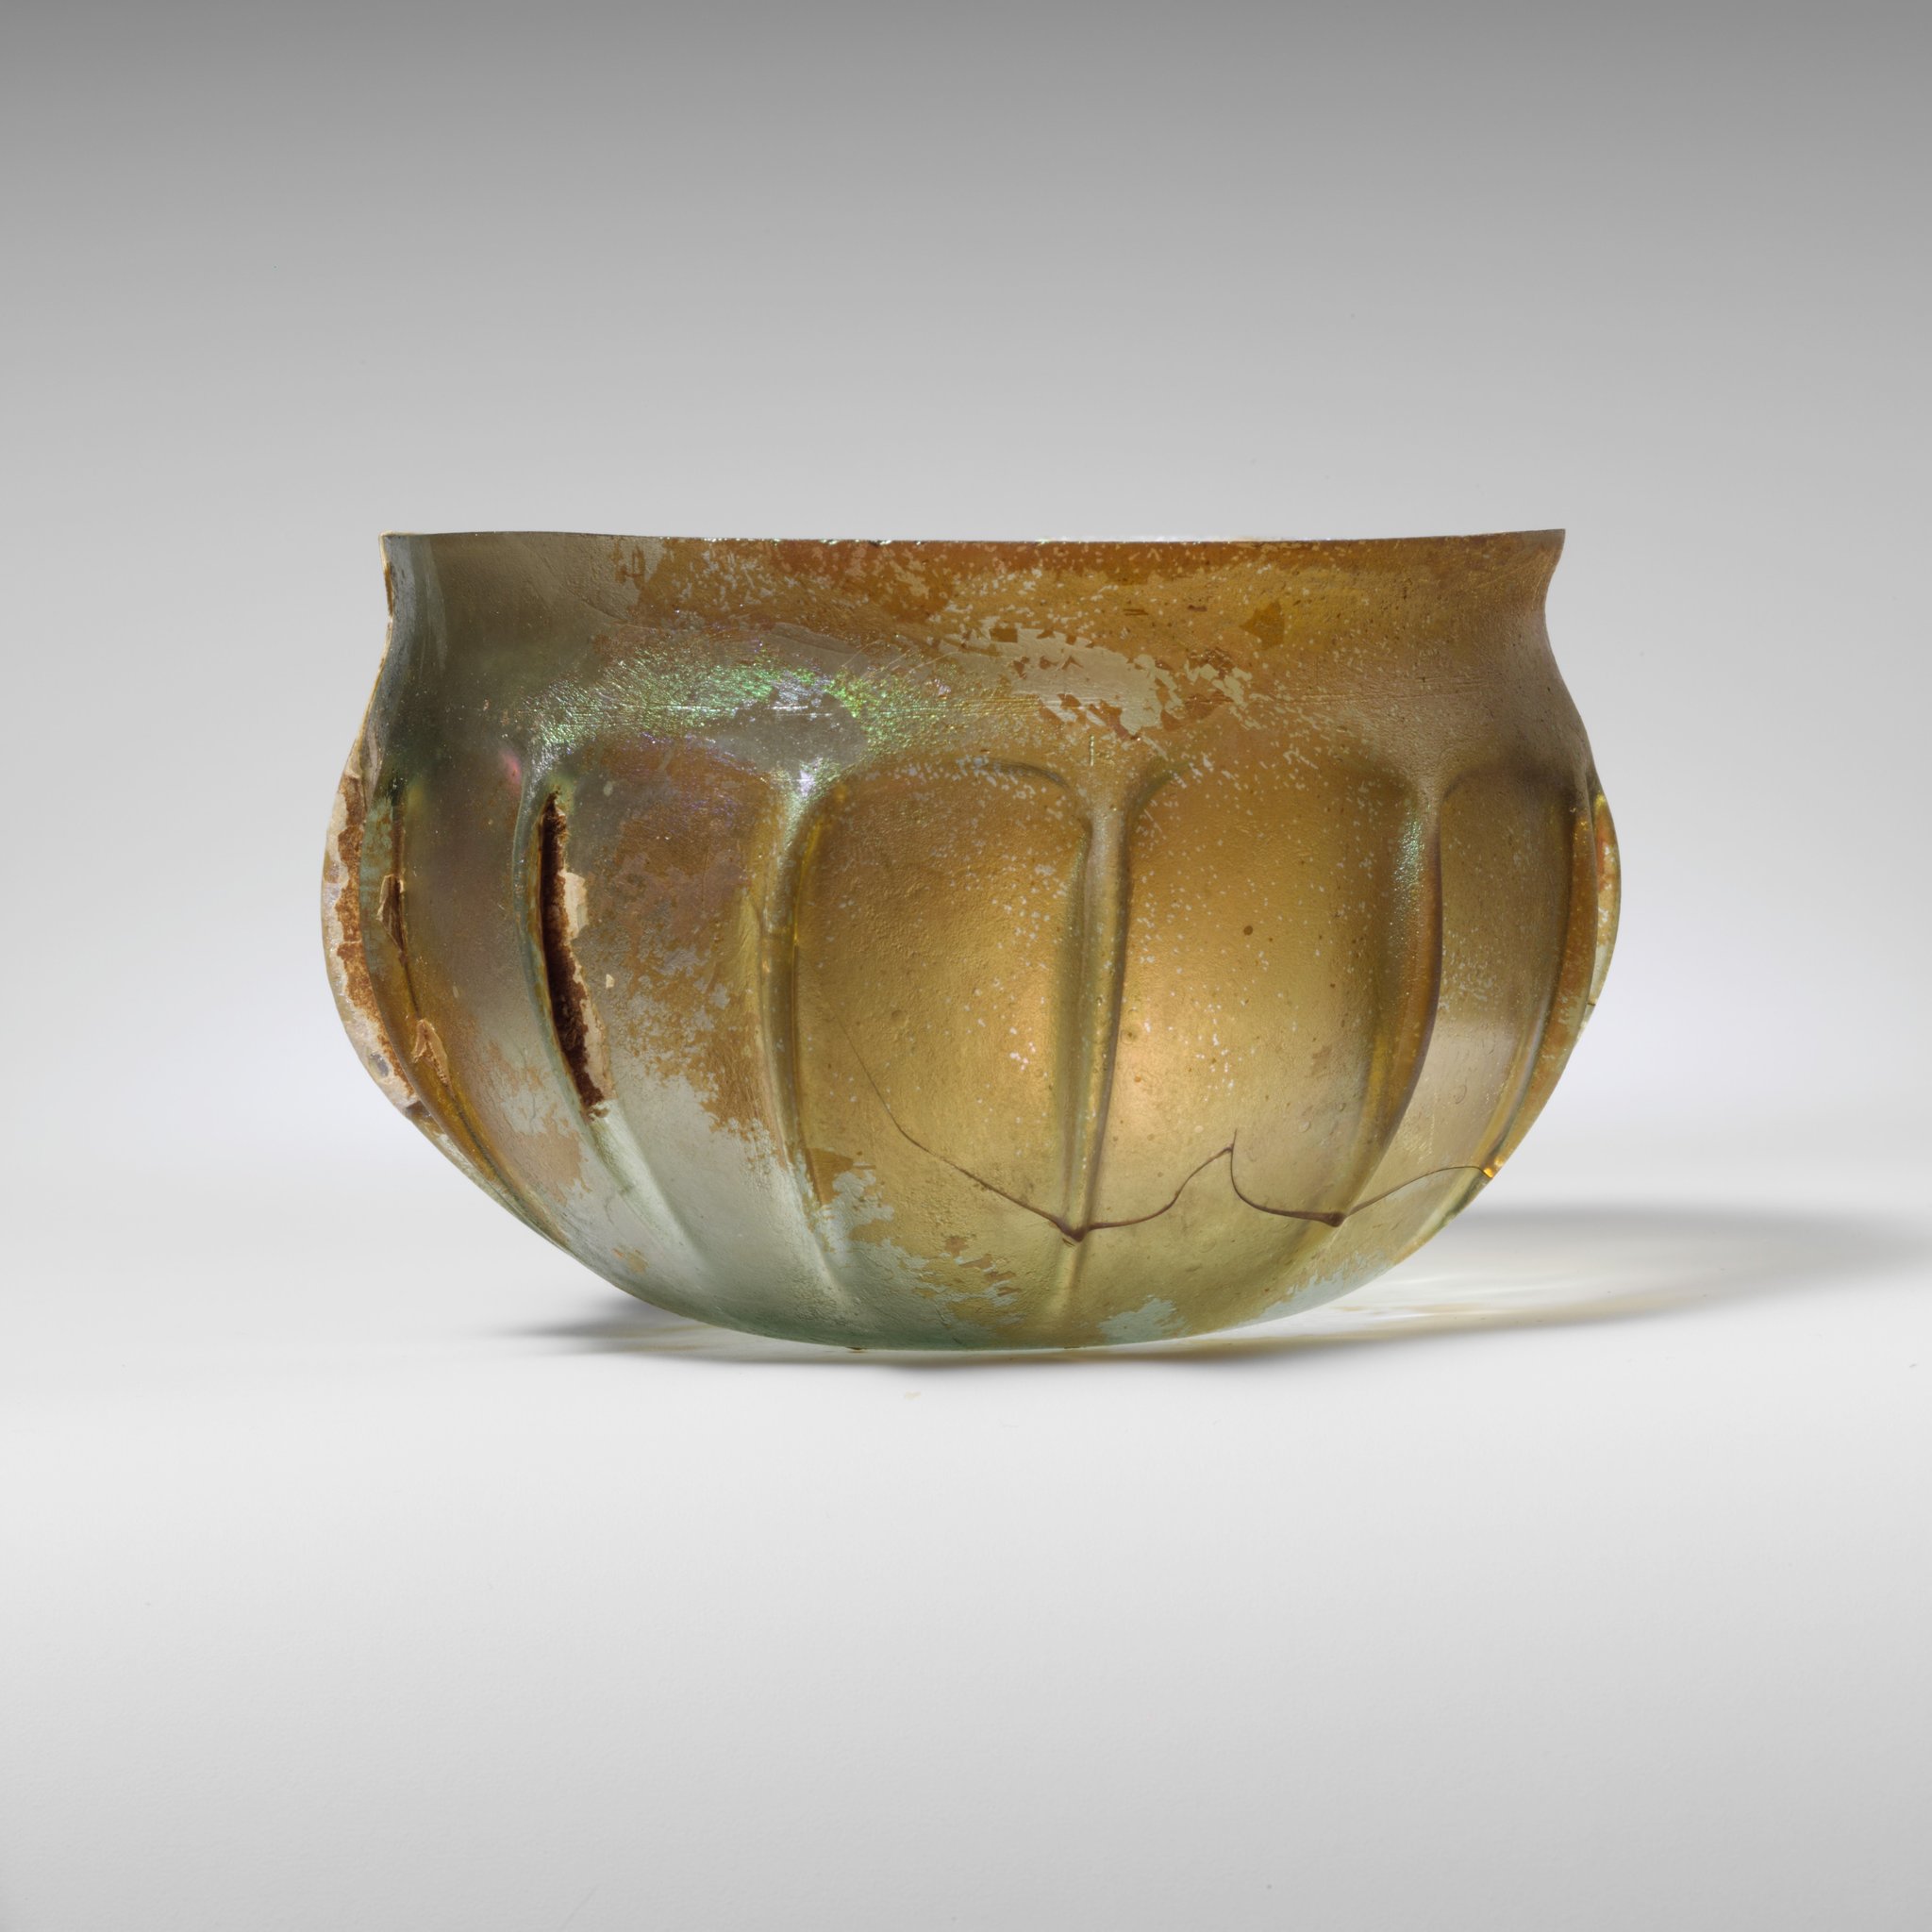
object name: bowl, rippenschale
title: Glass ribbed bowl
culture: roman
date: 34-66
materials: glass